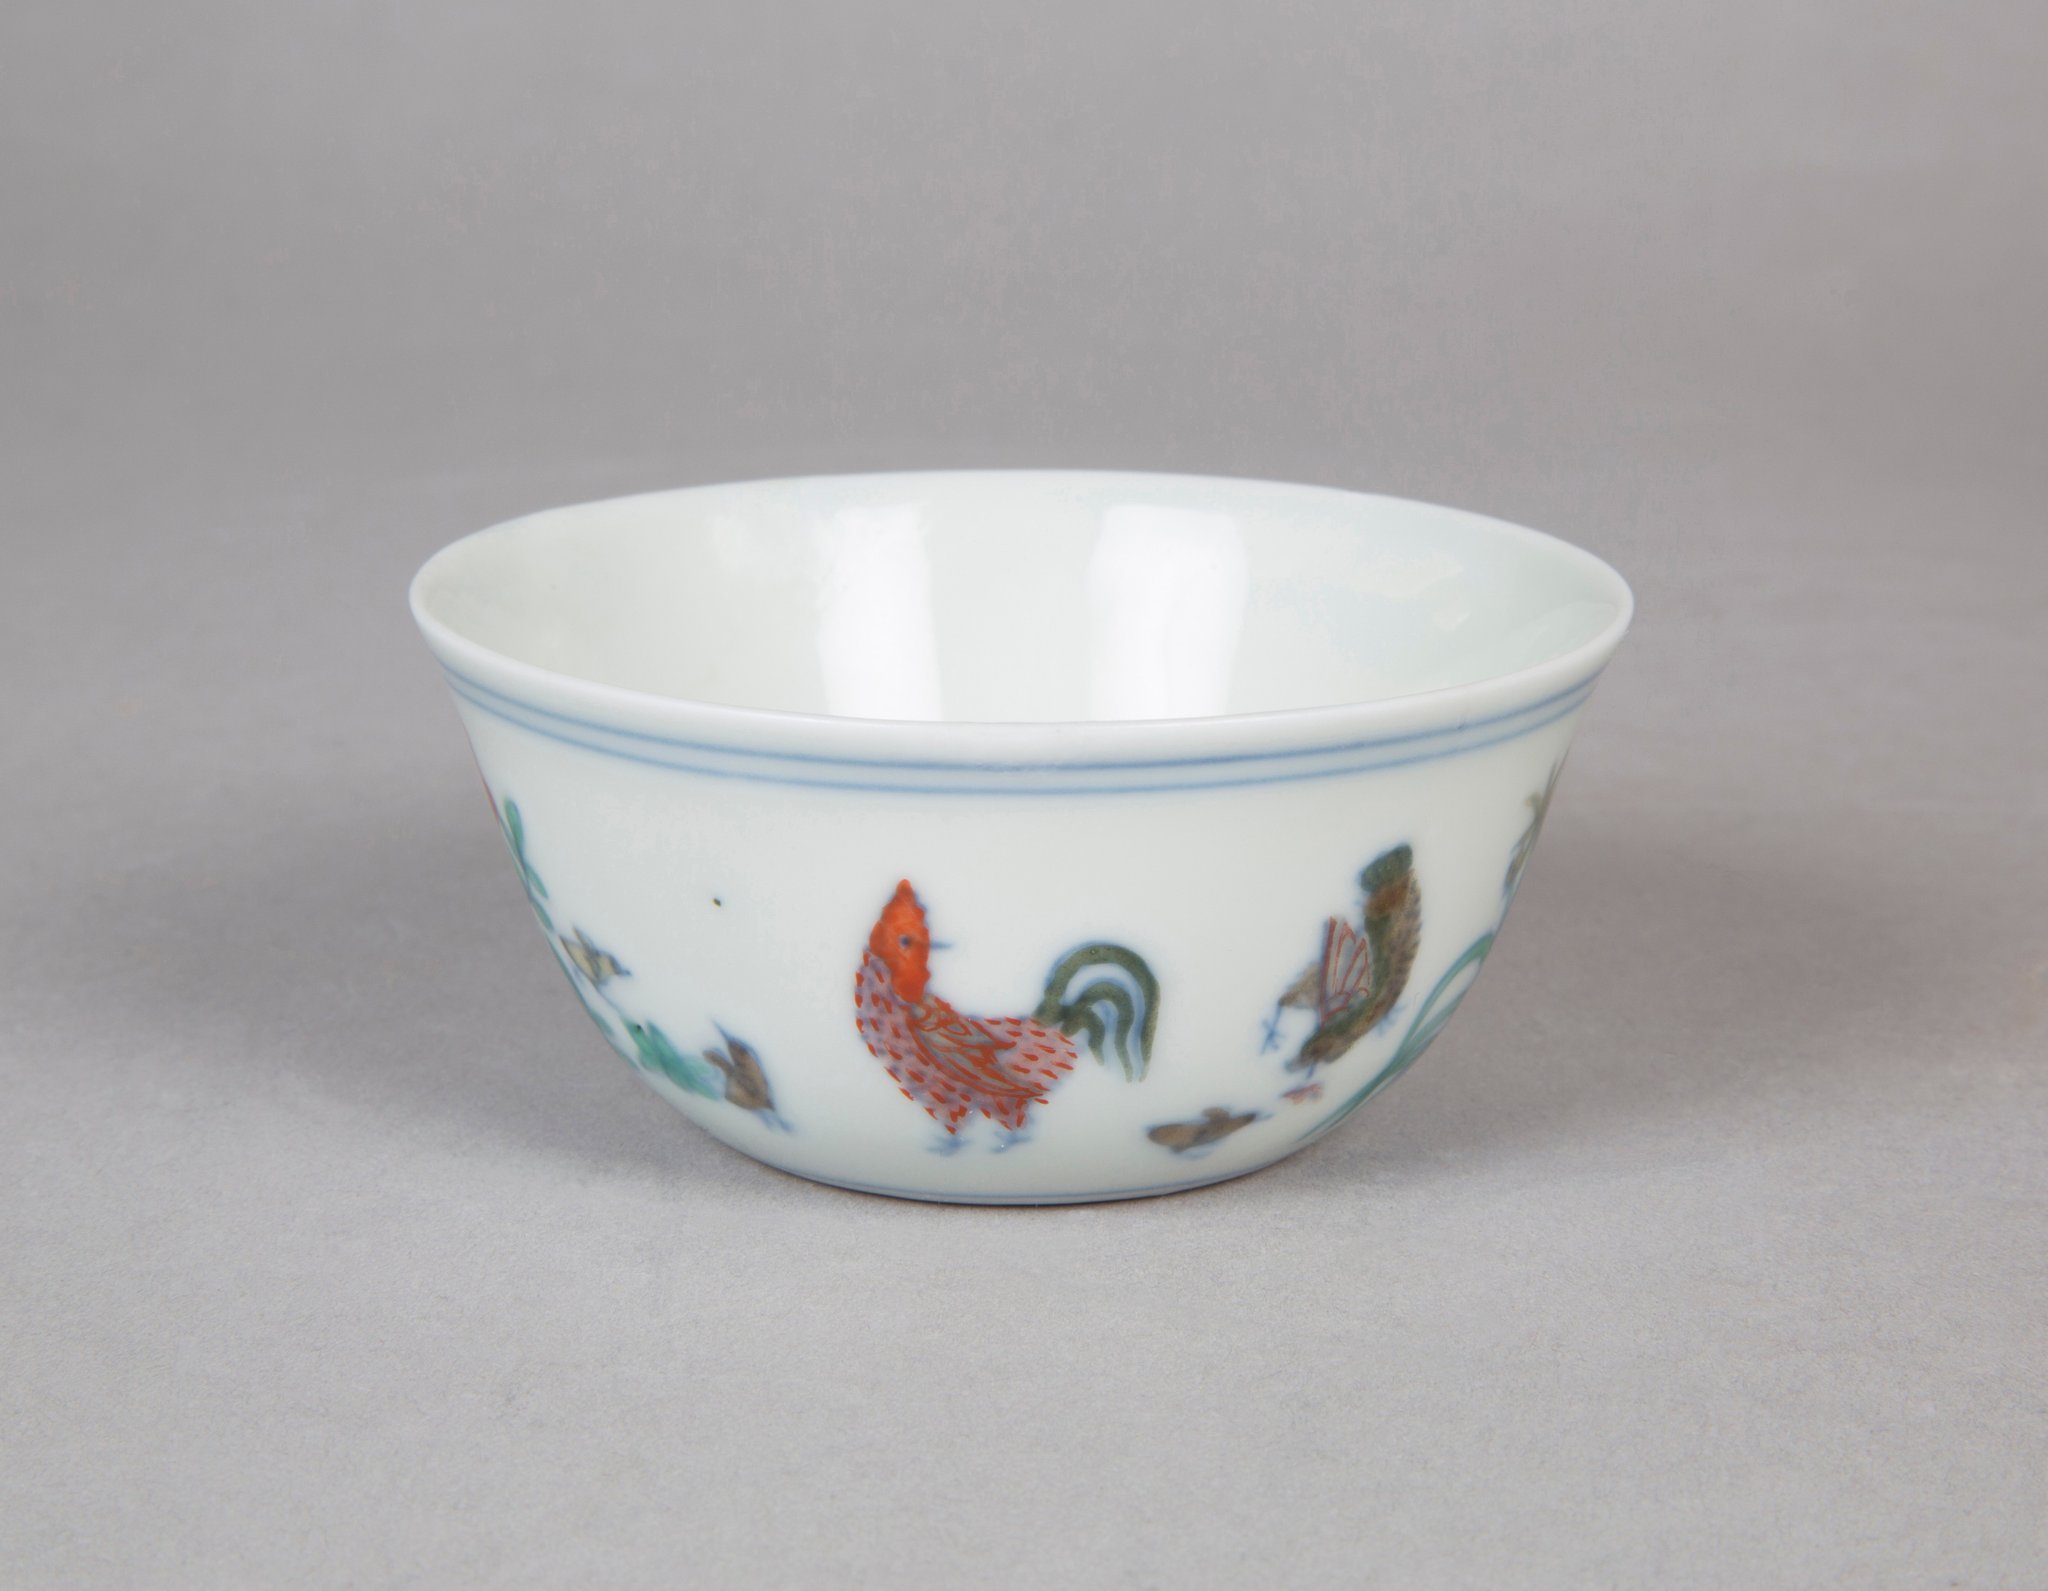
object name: cup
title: Chicken cup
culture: chinese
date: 1465-1487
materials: cobalt, enamel, porcelain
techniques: overglaze, painting, underglaze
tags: roosters